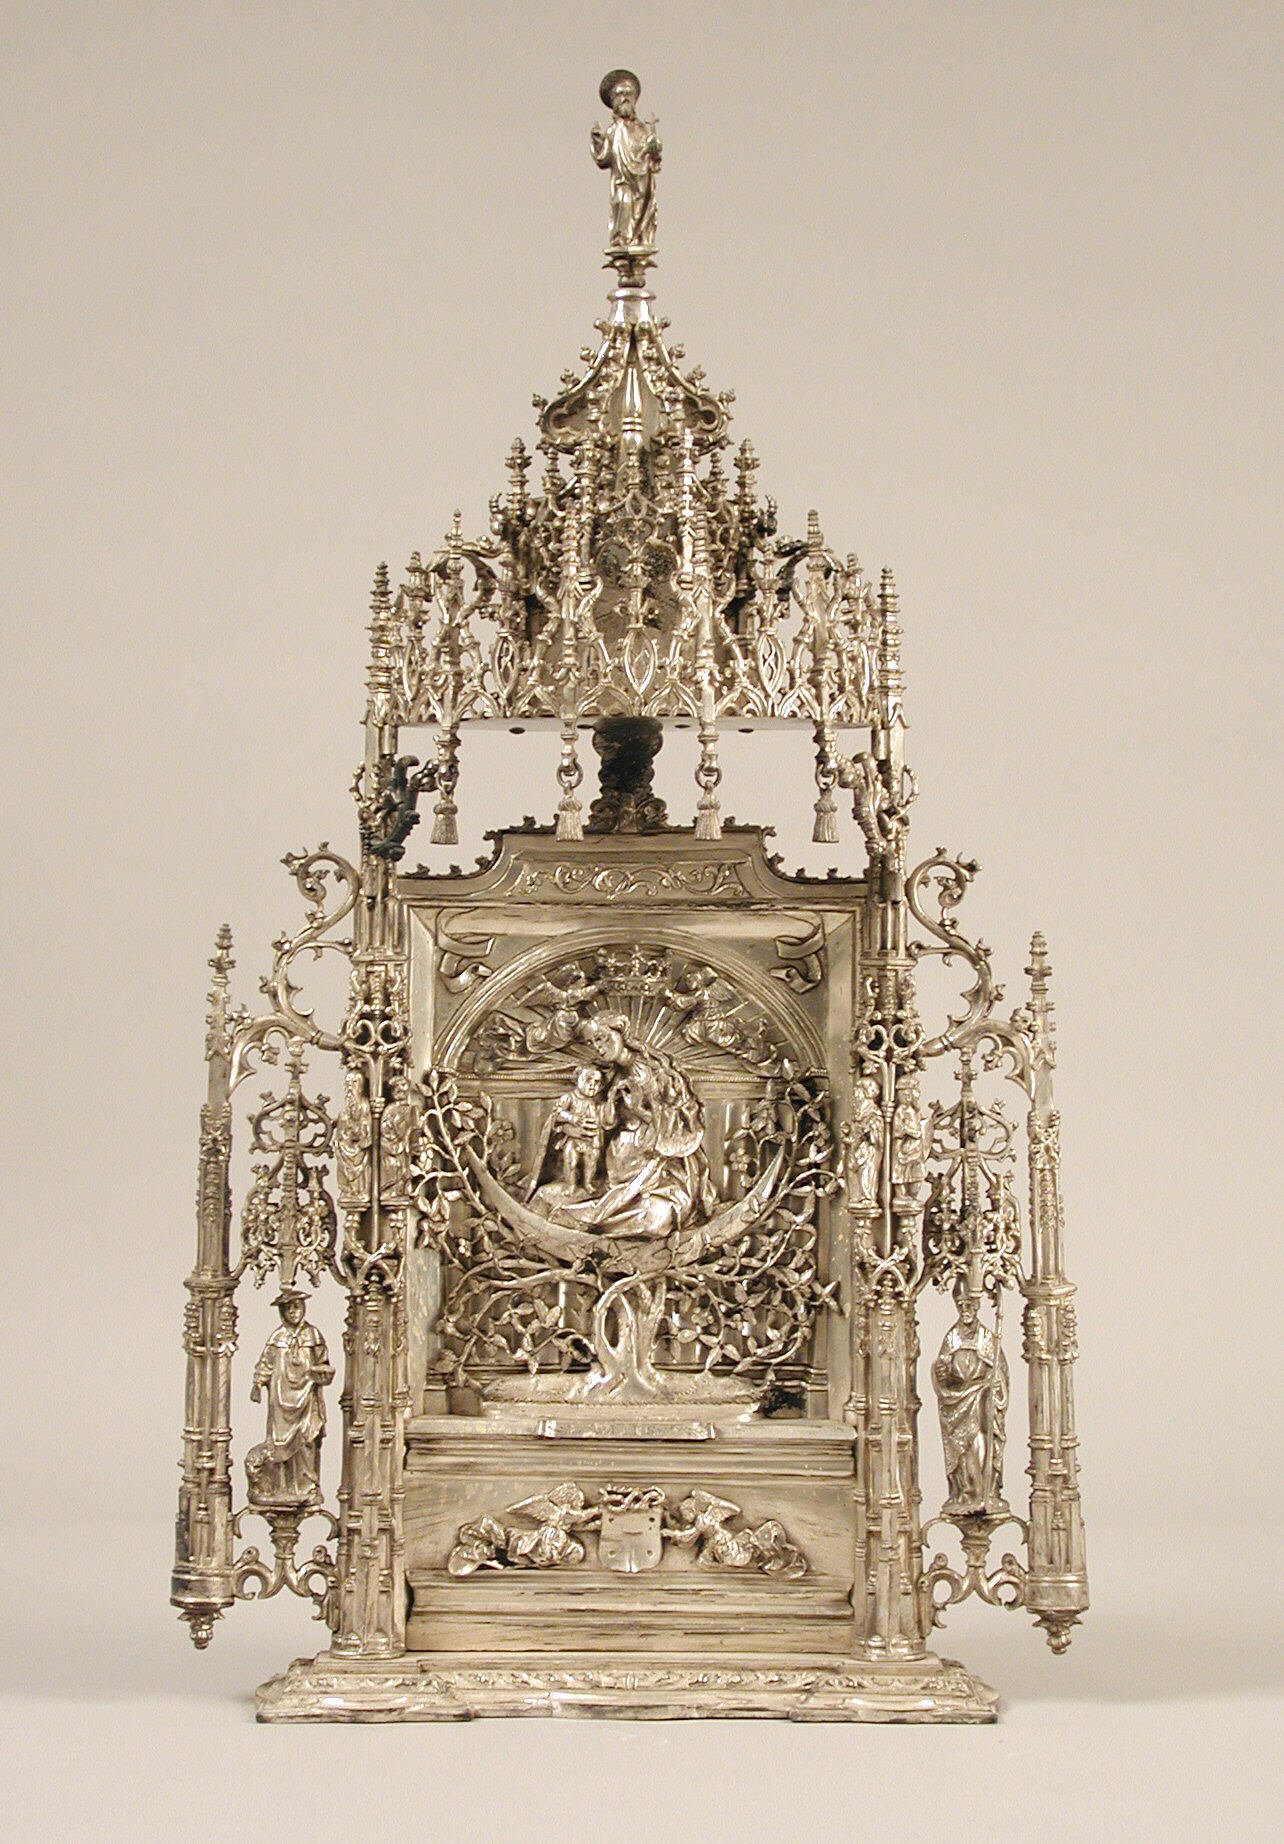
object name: pax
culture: portuguese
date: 1901-1933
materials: copper, silver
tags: christ,madonna and child